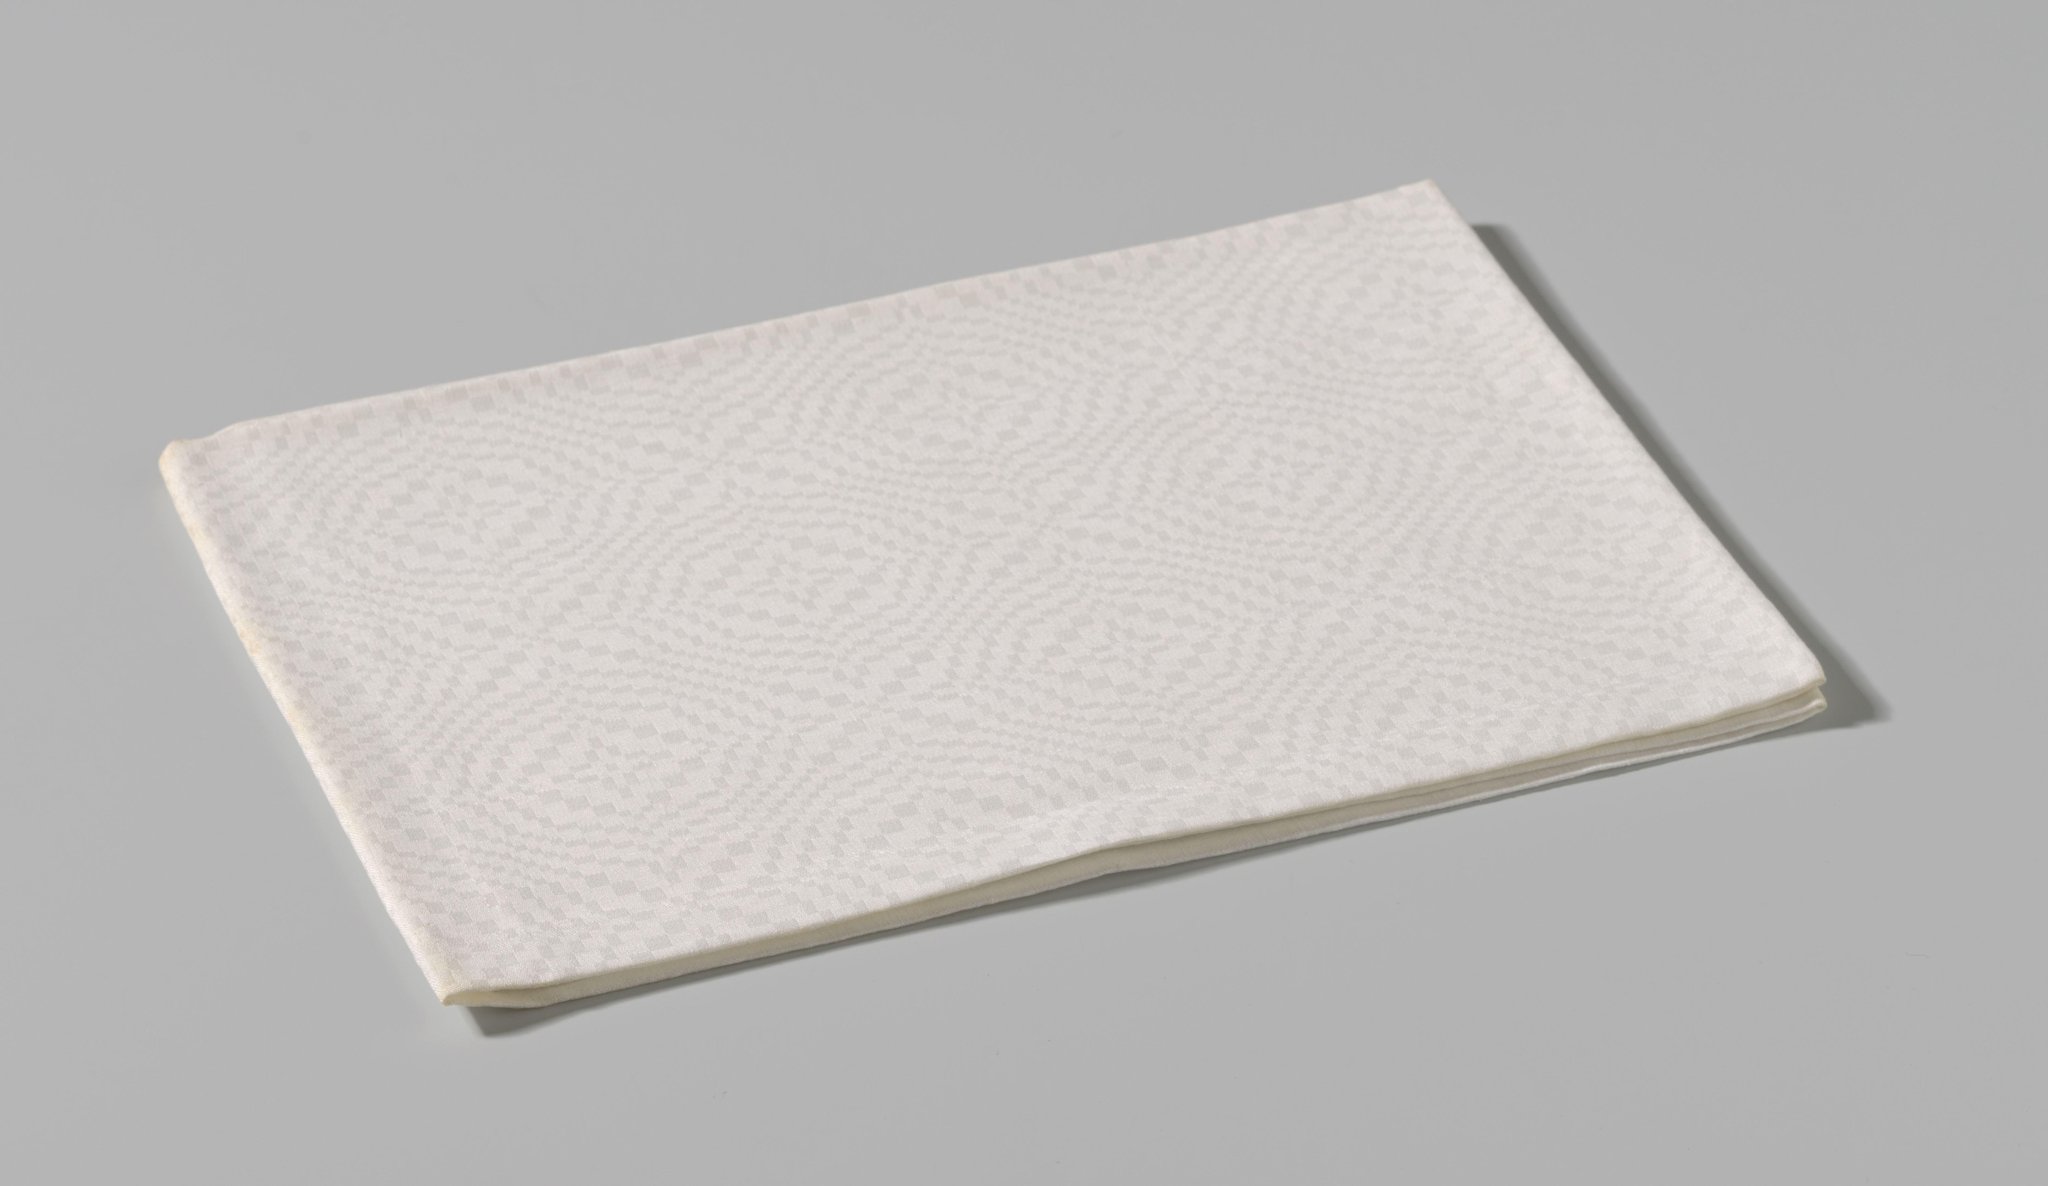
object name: napkin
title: Pellenpatroon, z.g. 'fijne molenwiek'. Merk: CH 42.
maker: Anonymous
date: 1600-1699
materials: linen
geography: northern netherlands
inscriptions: mark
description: Servet van wit linnen met een pellen patroon z.g. 'fijne molenwiek', merk CH 42.